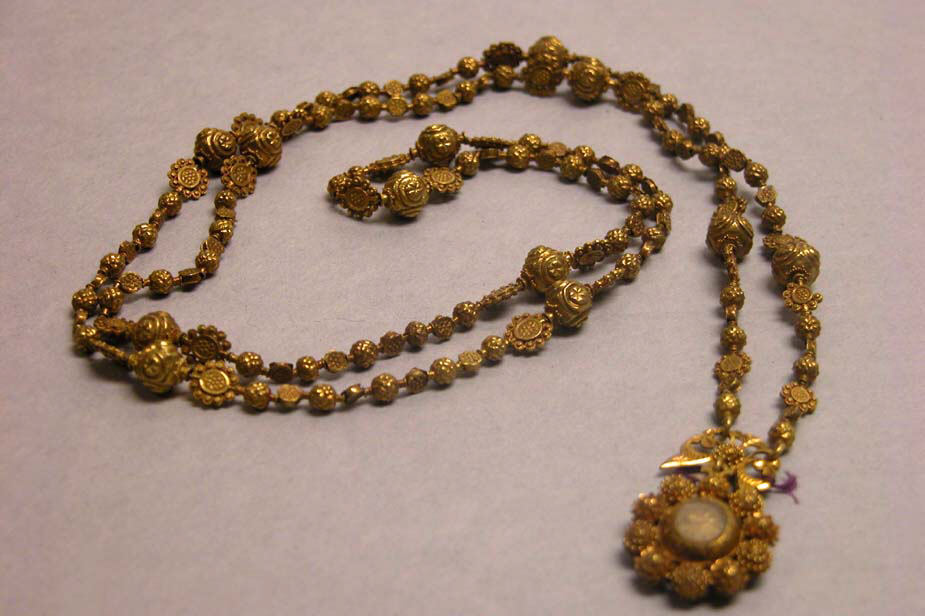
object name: rosary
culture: filipino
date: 1601-1900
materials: gold